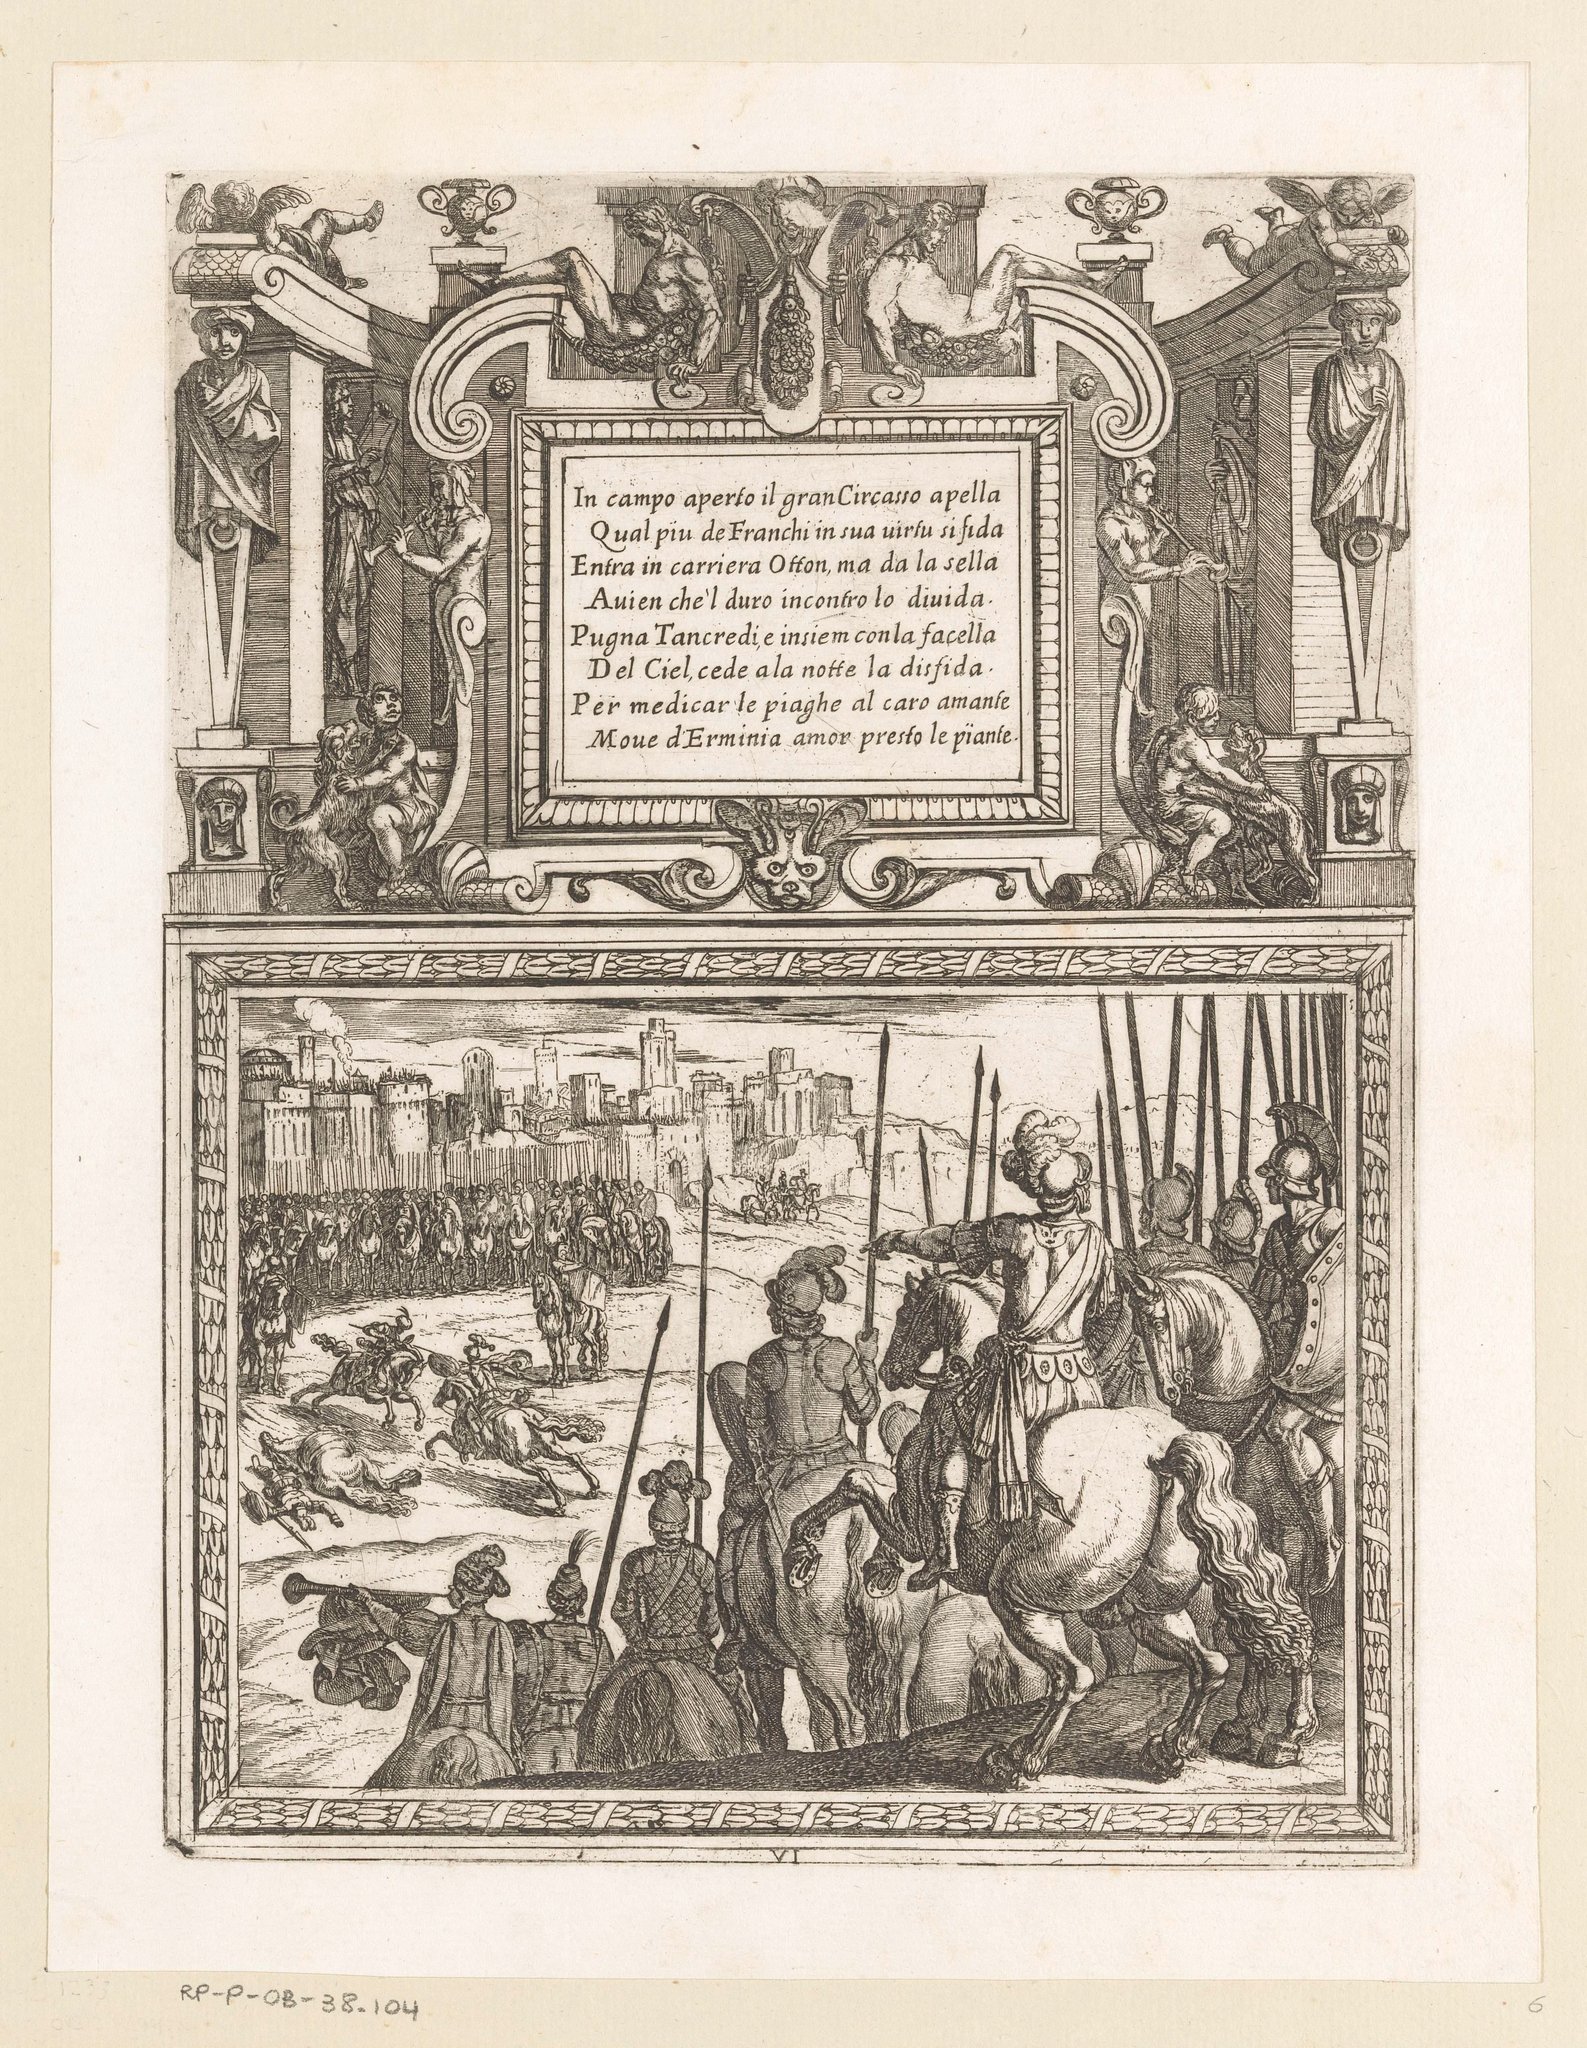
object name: print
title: Illustratie bij Canto VI van Tasso's 'Gerusalemme Liberata'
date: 1565-1630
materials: paper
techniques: etching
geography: italy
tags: ornaments ~ art, battle, warfare; military affairs (+ cavalry, horsemen), militant proselytizing: religious war, crusade, etc., ornament ~ cartouche, (scenes from) specific works of literature: tasso, gerusalemme liberata, knight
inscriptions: collector's mark: Lugt 240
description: Deze prent maakt deel uit van een reeks van twintig prenten met ornamentele sierlijsten met daarin voorstellingen van scènes uit Tasso's 'Jeruzalem verlost', een episch gedicht geschreven door de Italiaanse dichter Torquato Tasso en voor het eerst gepubliceerd in 1581. Het verhaal vertelt grotendeels in fictie over de Eerste Kruistocht waarin de christenen, geleid door Godfried van Bouillon, de strijd aangaan met de moslims om het Beleg van Jeruzalem.